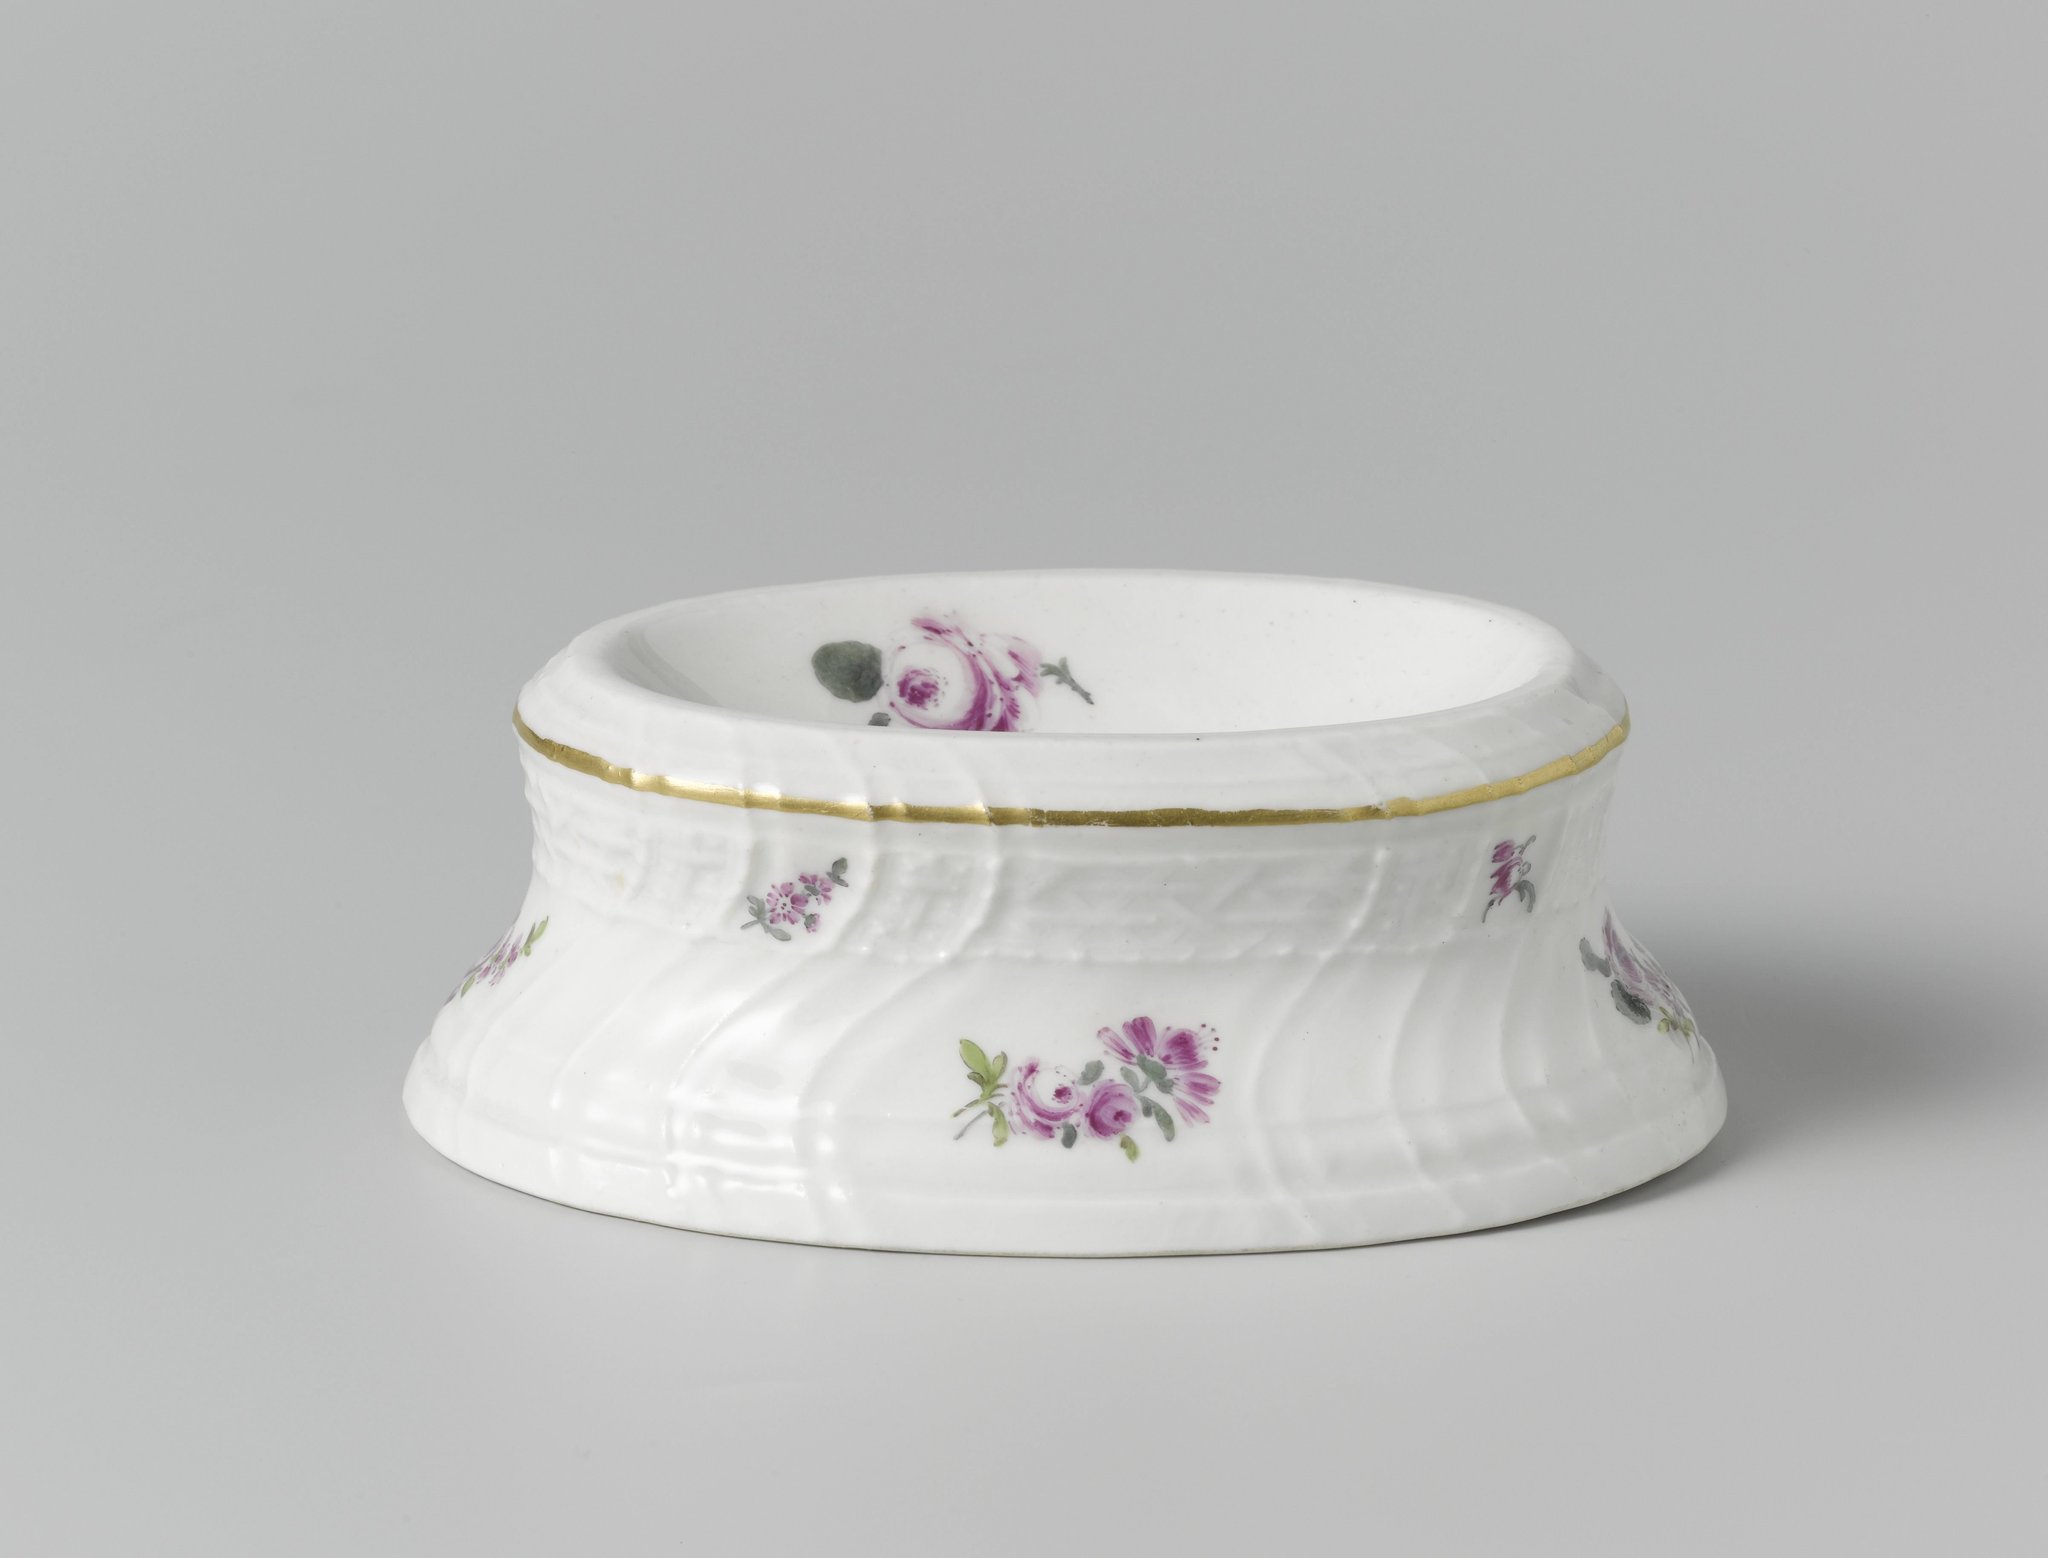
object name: eating drinking utensil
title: Zoutvat, veelkleurig beschilderd met Deutsche Blumen, insekten en vruchten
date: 1750-1760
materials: porcelain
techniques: painted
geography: meissen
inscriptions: factory mark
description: Ovaal zoutvat van beschilderd porselein. Het zoutvat heeft een ingesnoerde wand. De rand is versierd met het Neuozier-patroon in reliëf en de beschildering bestaat uit Deutsche Blumen, insekten en vruchten. Het zoutvat hoort bij een servies (BK-17474-1 t/m BK-17474-253). Het zoutvat is gemerkt.